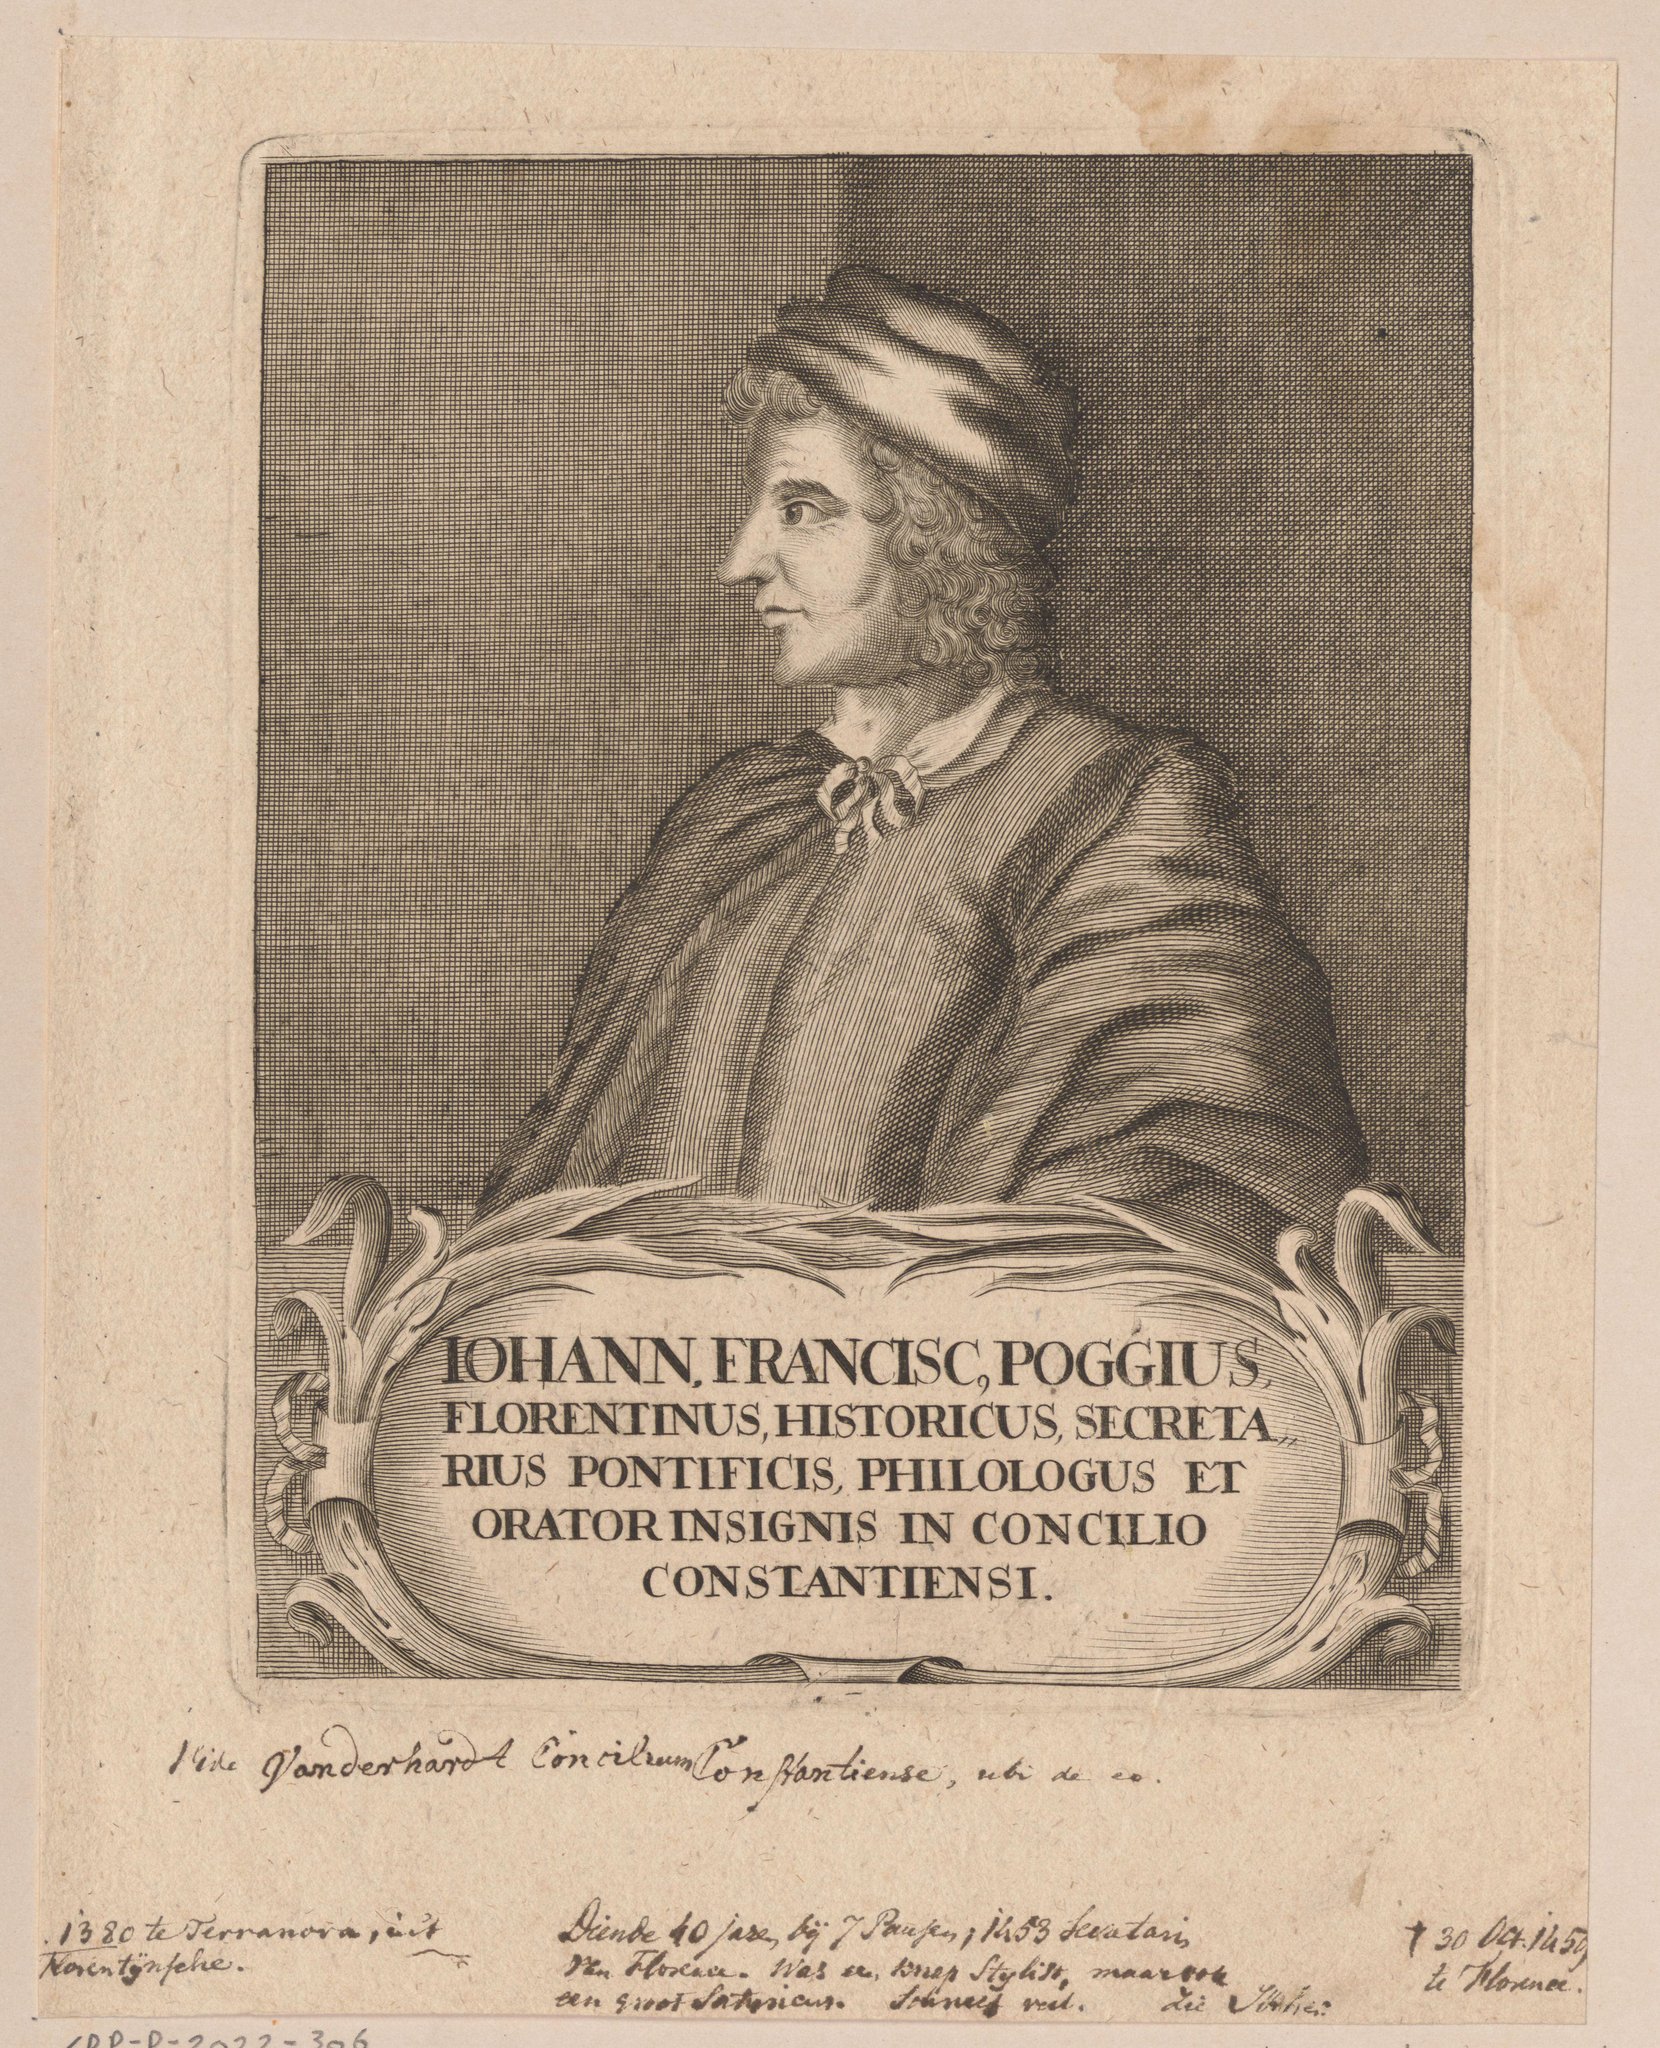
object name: print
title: Portret van Gian Francesco Poggio Bracciolini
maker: Anonymous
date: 1698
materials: paper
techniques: engraving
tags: scholar, philosopher, historical persons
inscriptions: inscription, inscription: ‘1[...]de Vanderhardt Concil[...]um (...)’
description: Prent waarschijnlijk uit: Van der Hardt, Herman. Rerum concilii constantiensis, de religionis et fidei momentis (...). Frankfurt am Main en Leipzig: Christian Gensch, 1698.